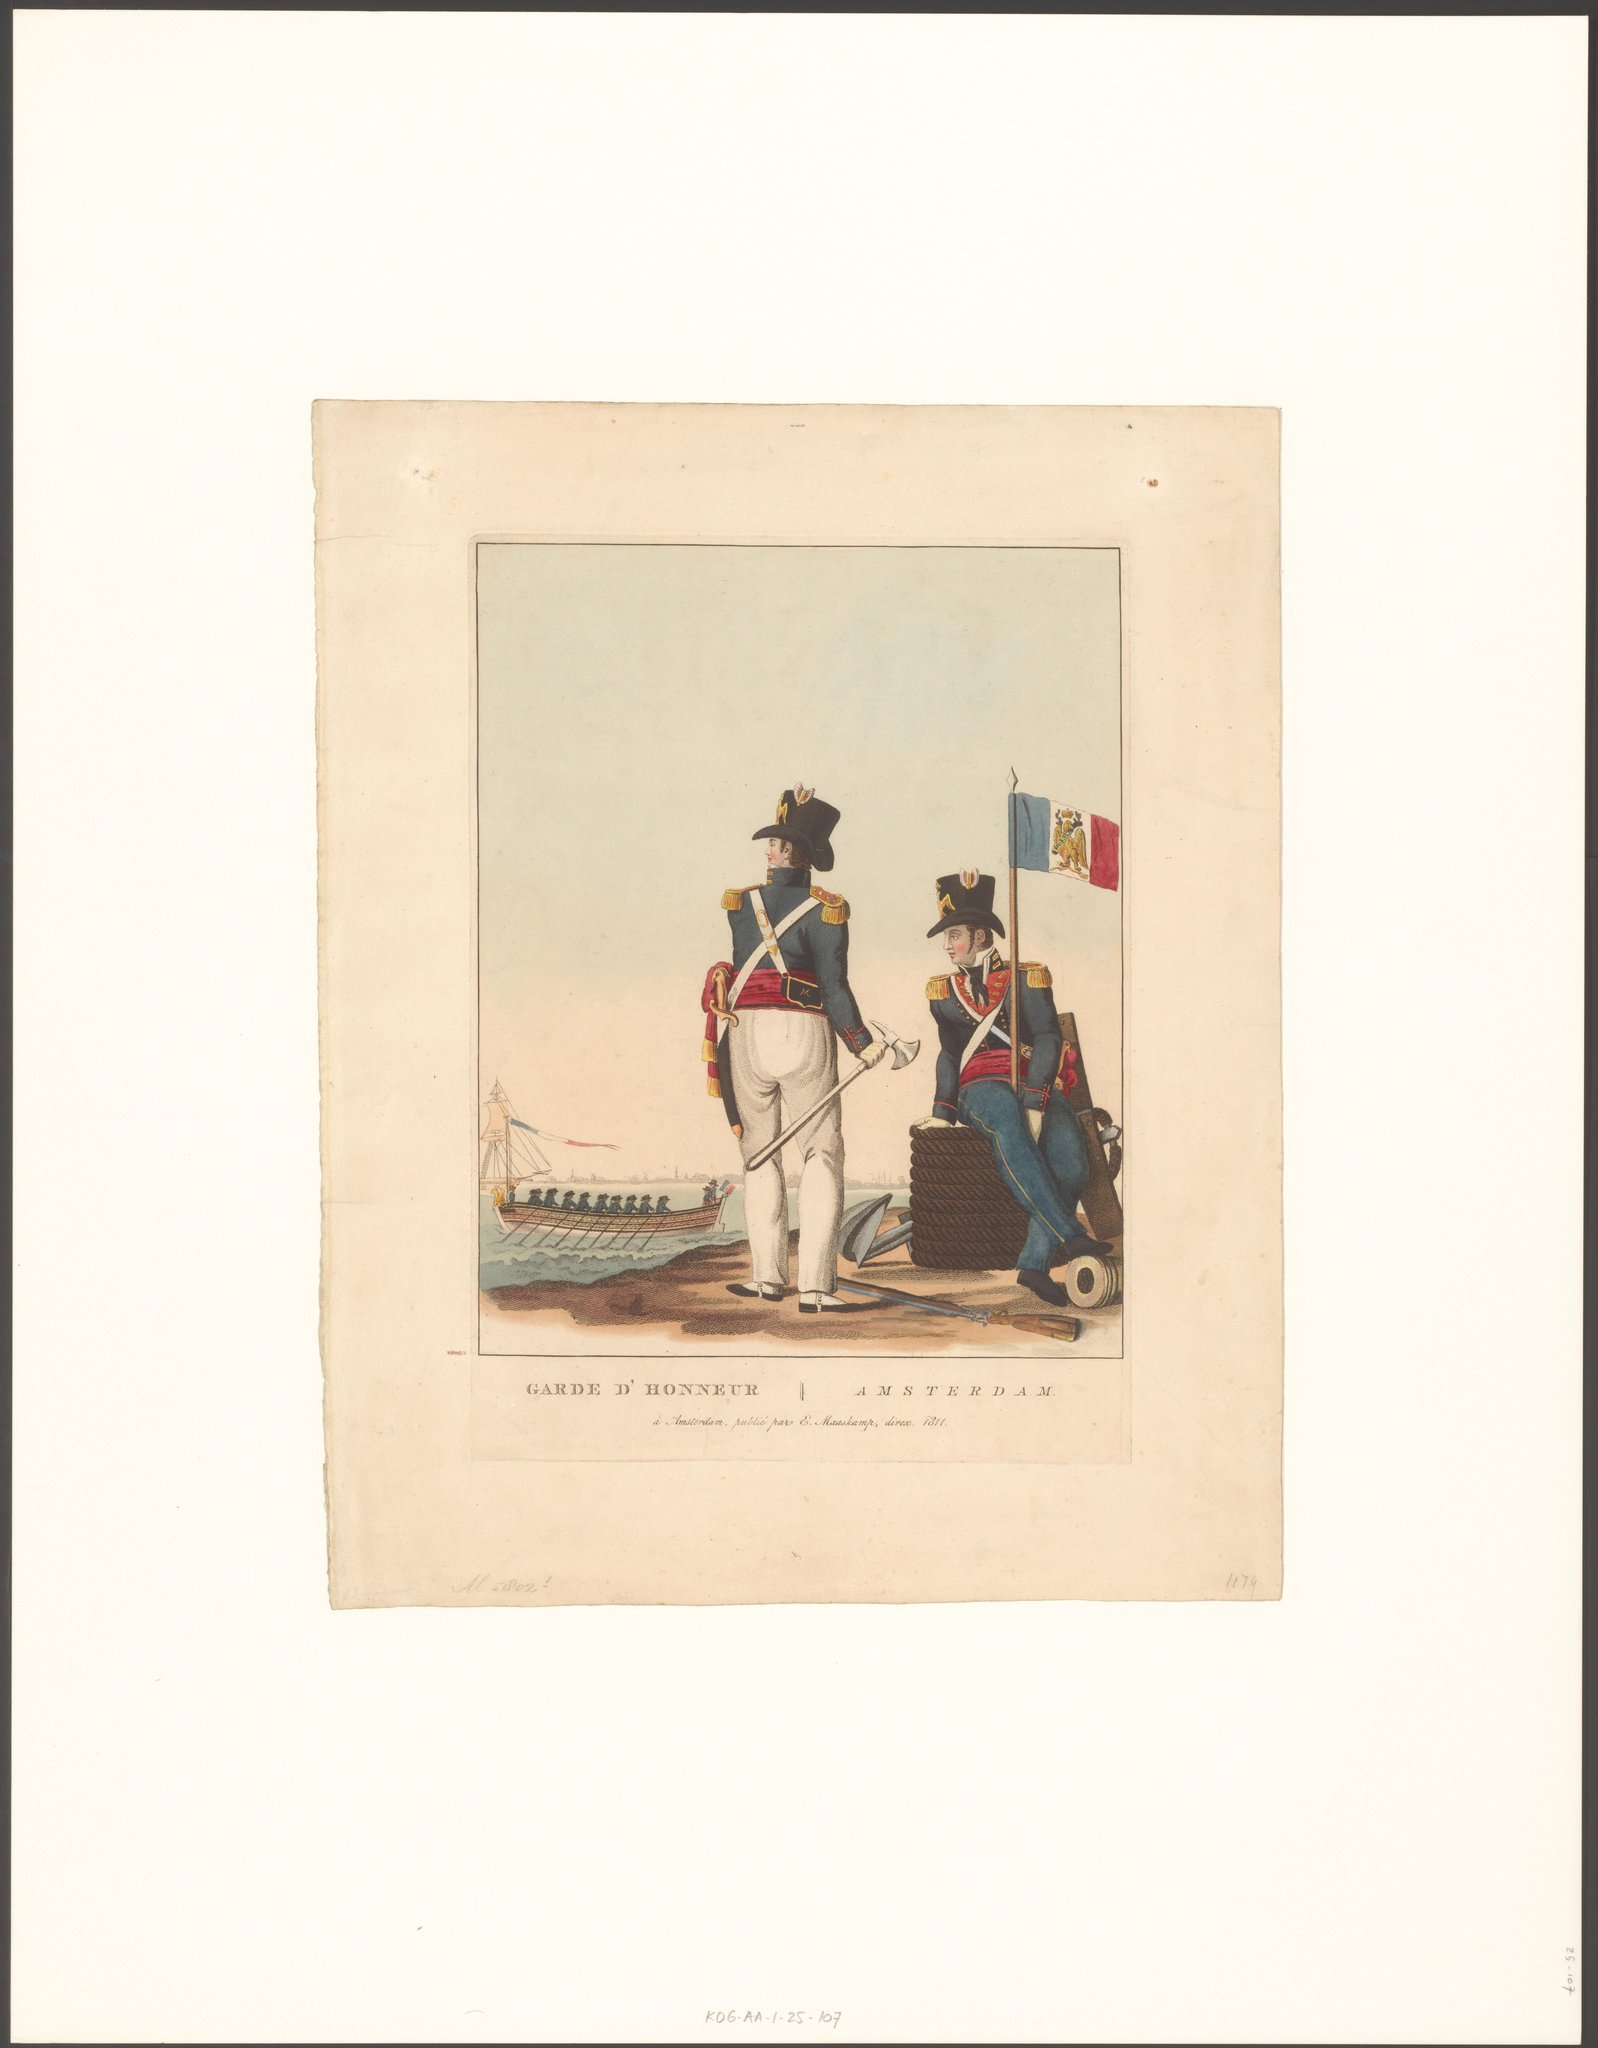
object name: print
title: Garde d'Honneur / Amsterdam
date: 1811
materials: paper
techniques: etching, hand coloring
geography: amsterdam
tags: napoleon i (emperor of the french), guard of honour, (military) uniforms, amsterdam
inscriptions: inscription: ‘Juny 1810’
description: Met vlag of guidon van de divisie Forbin. Onderwerpsrubriek binnen de Atlas Amsterdam: Krijgswezen I: De Admiraliteit van Amsterdam, B. Vlootvoogden en schepelingen; Herinneringen daaraan.